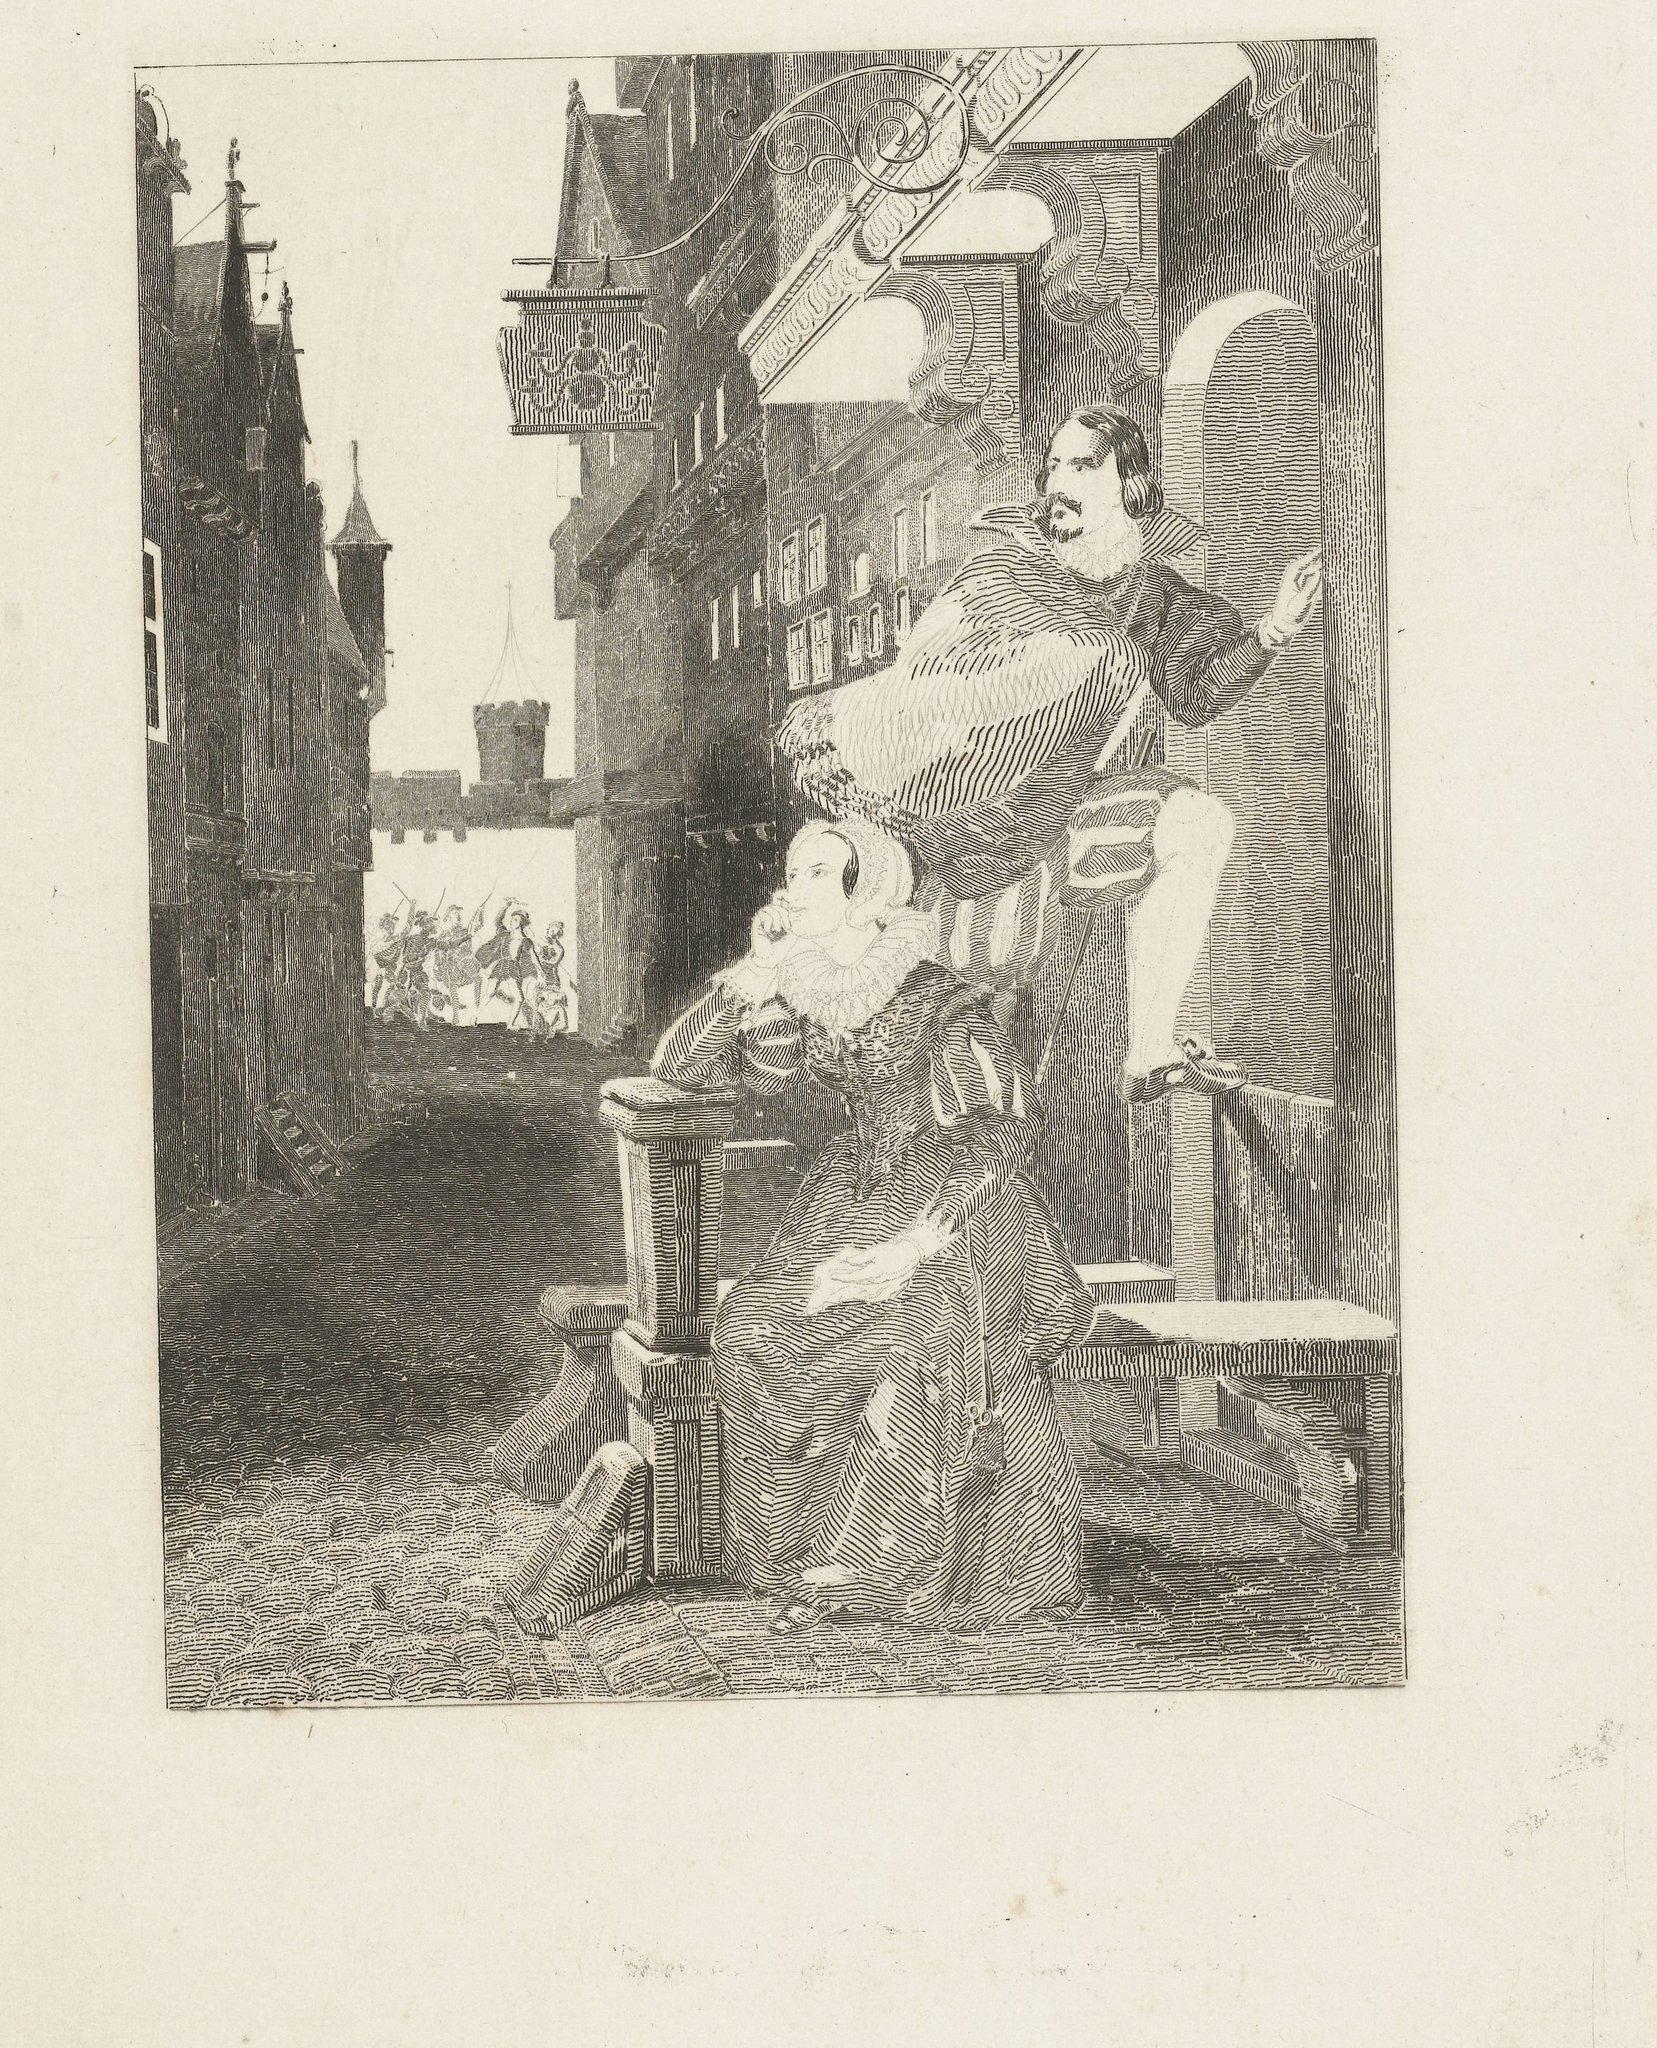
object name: book illustration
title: Graaf Leicester vlucht in een huis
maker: henricus wilhelmus couwenberg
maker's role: draughtsman, print maker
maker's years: 1814-1845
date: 1841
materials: paper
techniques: engraving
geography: amsterdam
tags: robert dudley (1st earl of leicester), hiding, hiding oneself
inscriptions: collector's mark: Lugt 2228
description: Op de vlucht voor een oproerige muite vlucht graaf Leicester in een herberg. Voor het huis zit op een bank een vrouw die voor zich uit staart en hem niet schijnt op te merken.